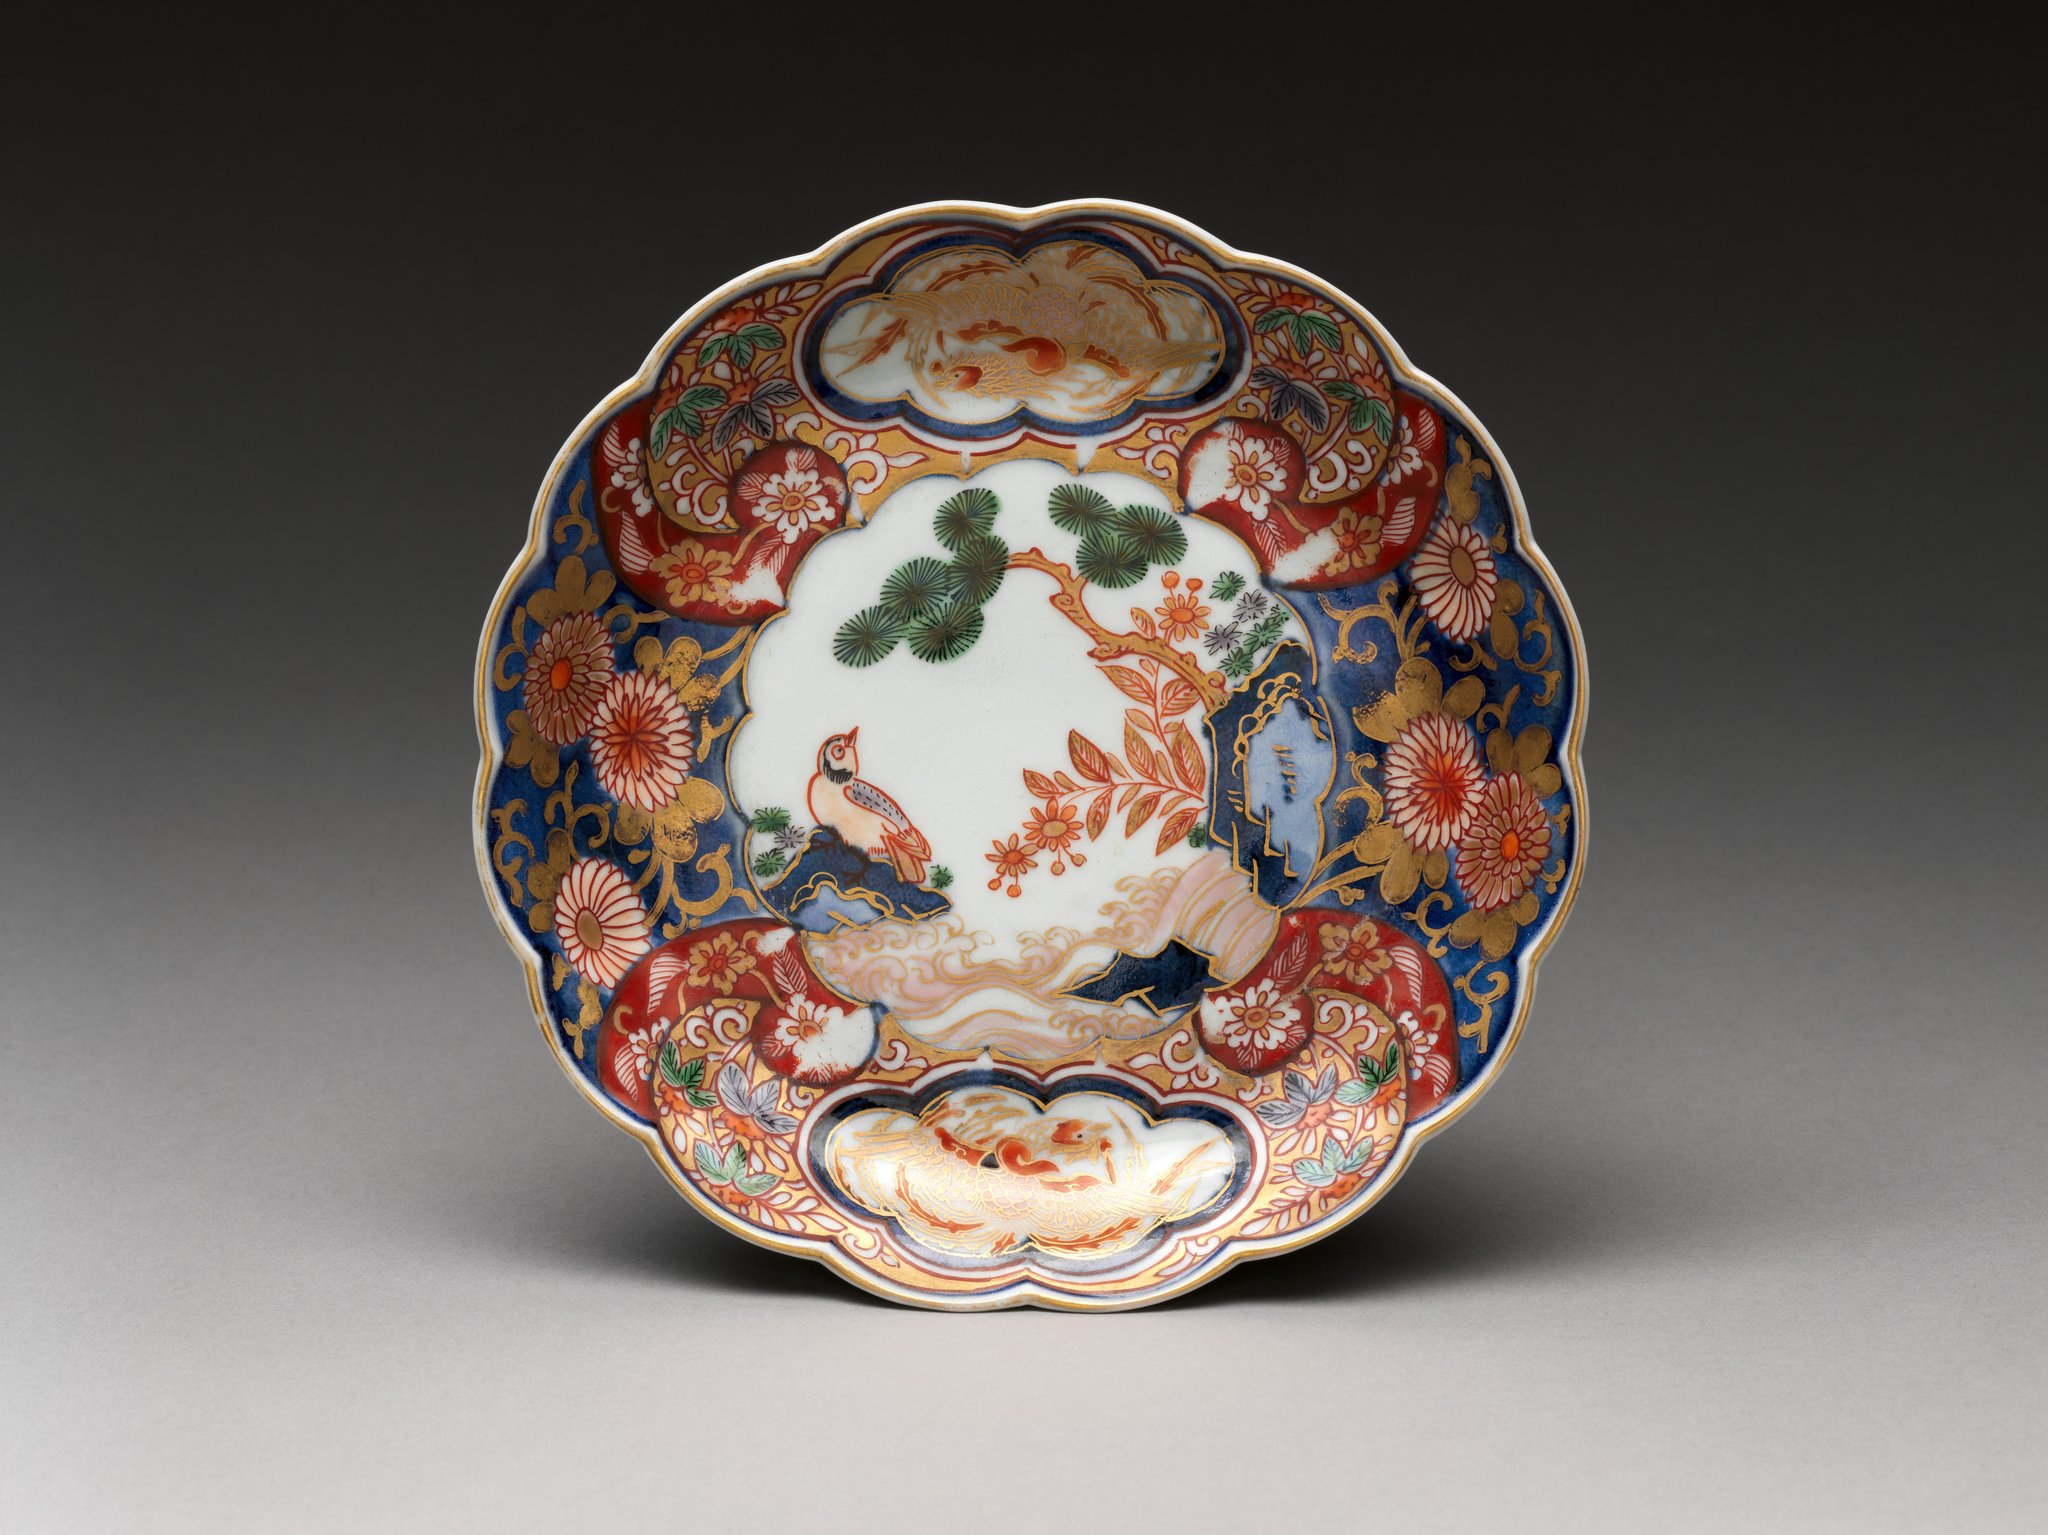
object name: dish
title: Dish with rocks, flowers, and birds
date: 1710-1730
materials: enamel, glaze, hard paste porcelain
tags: birds,flowers,trees